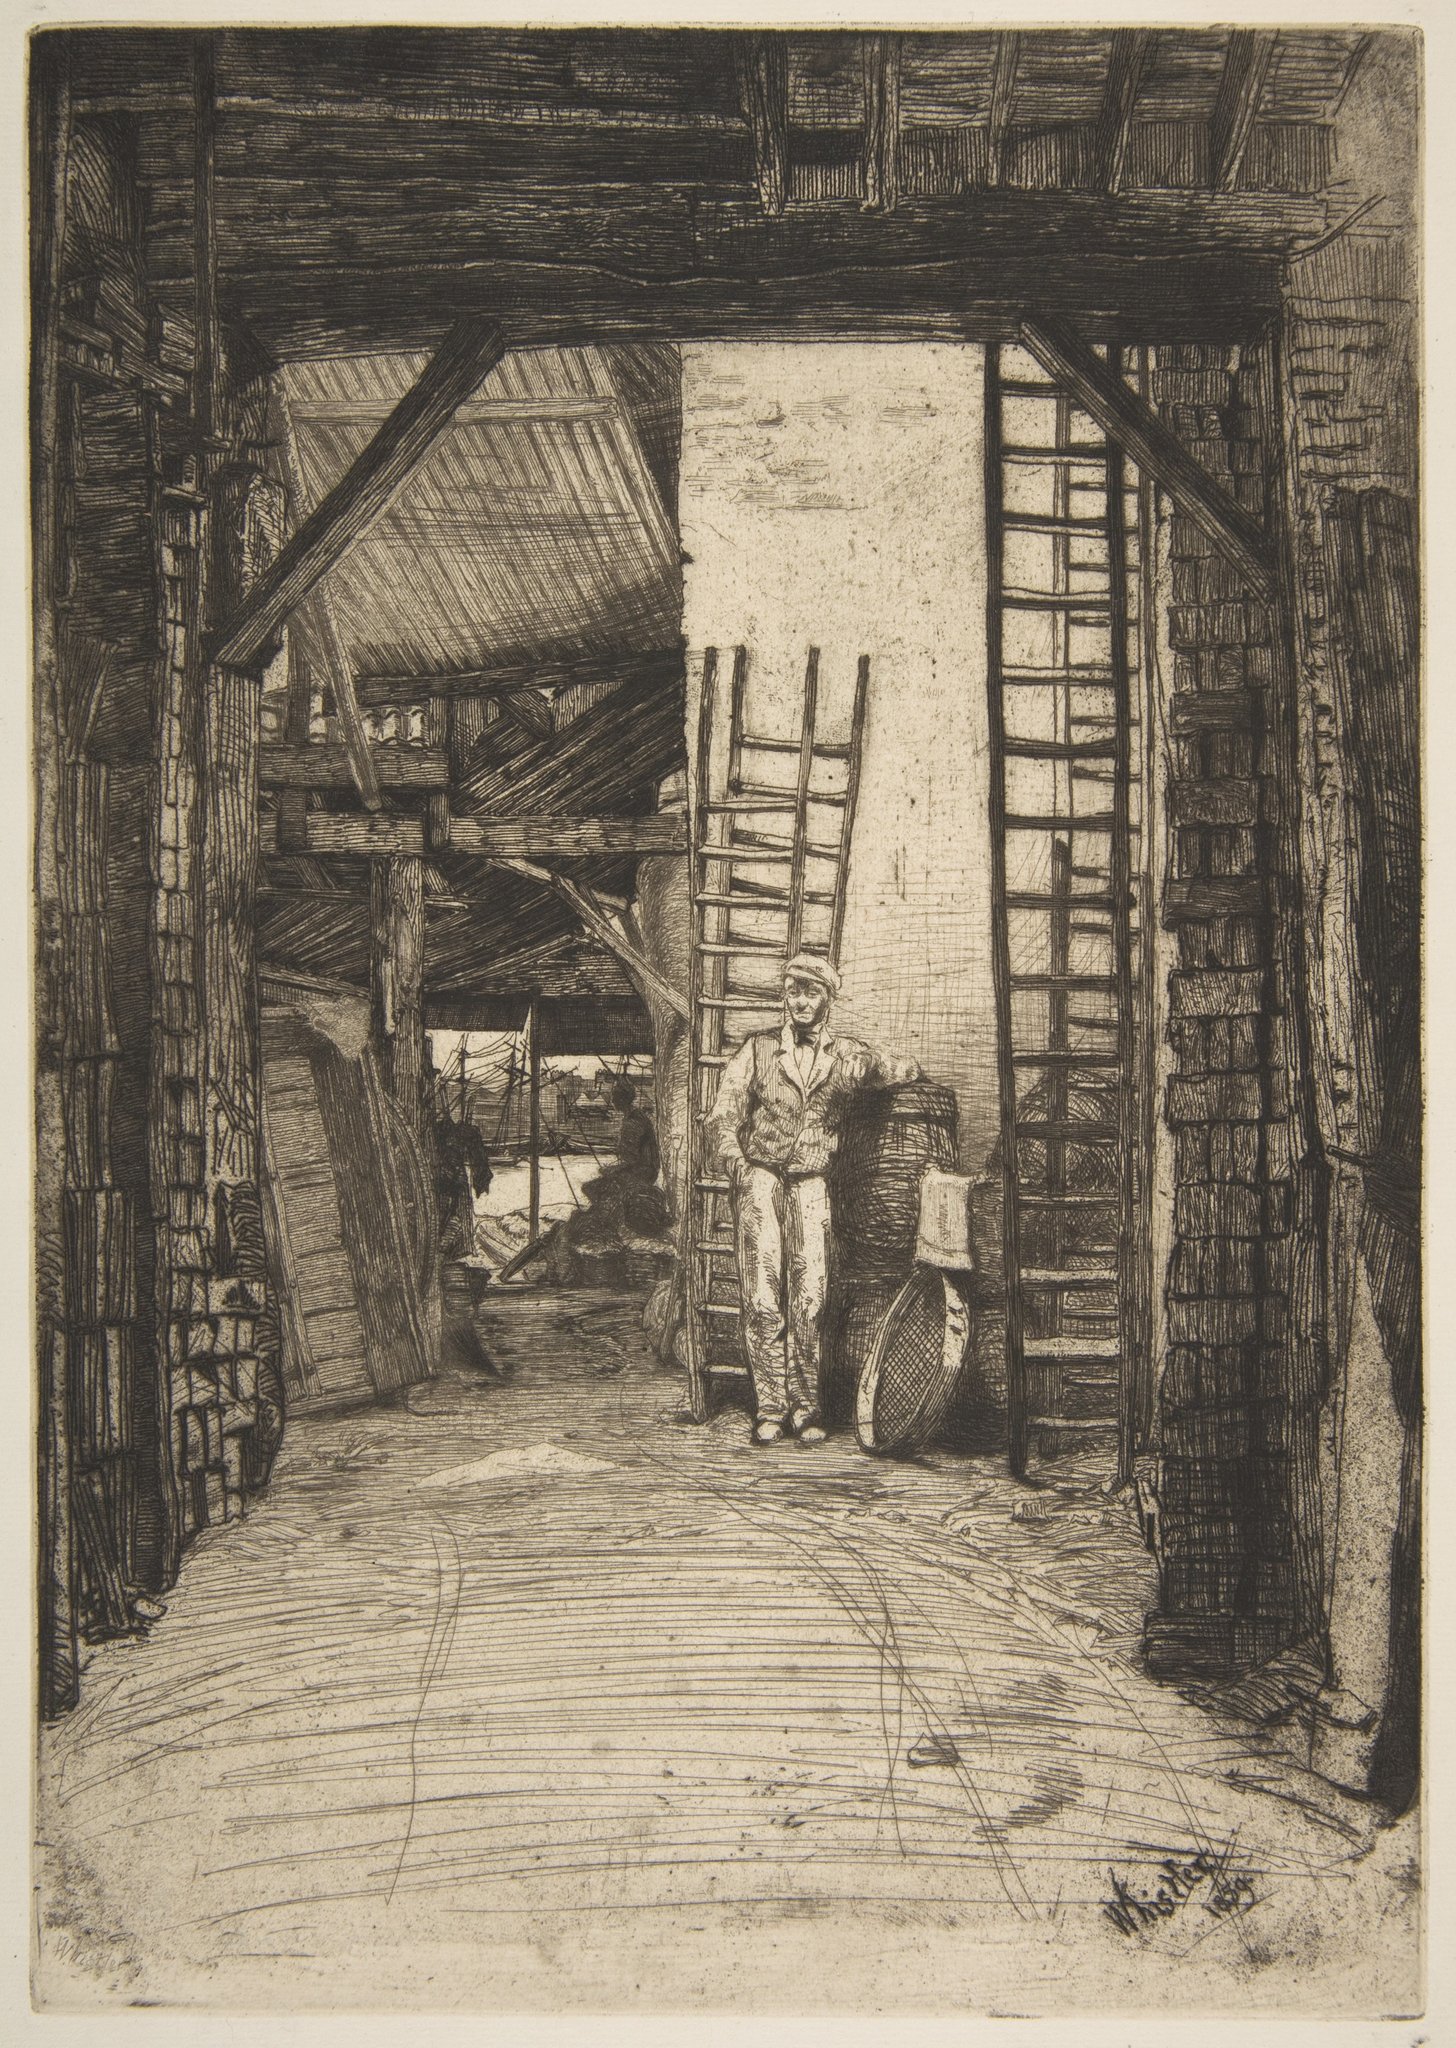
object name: print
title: The Lime-Burner (W. Jones, Lime-Burner, Thames Street)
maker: james mcneill whistler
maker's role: artist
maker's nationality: american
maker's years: 1834-1903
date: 1859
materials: ink, paper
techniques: drypoint, etching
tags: streets,men,ladders